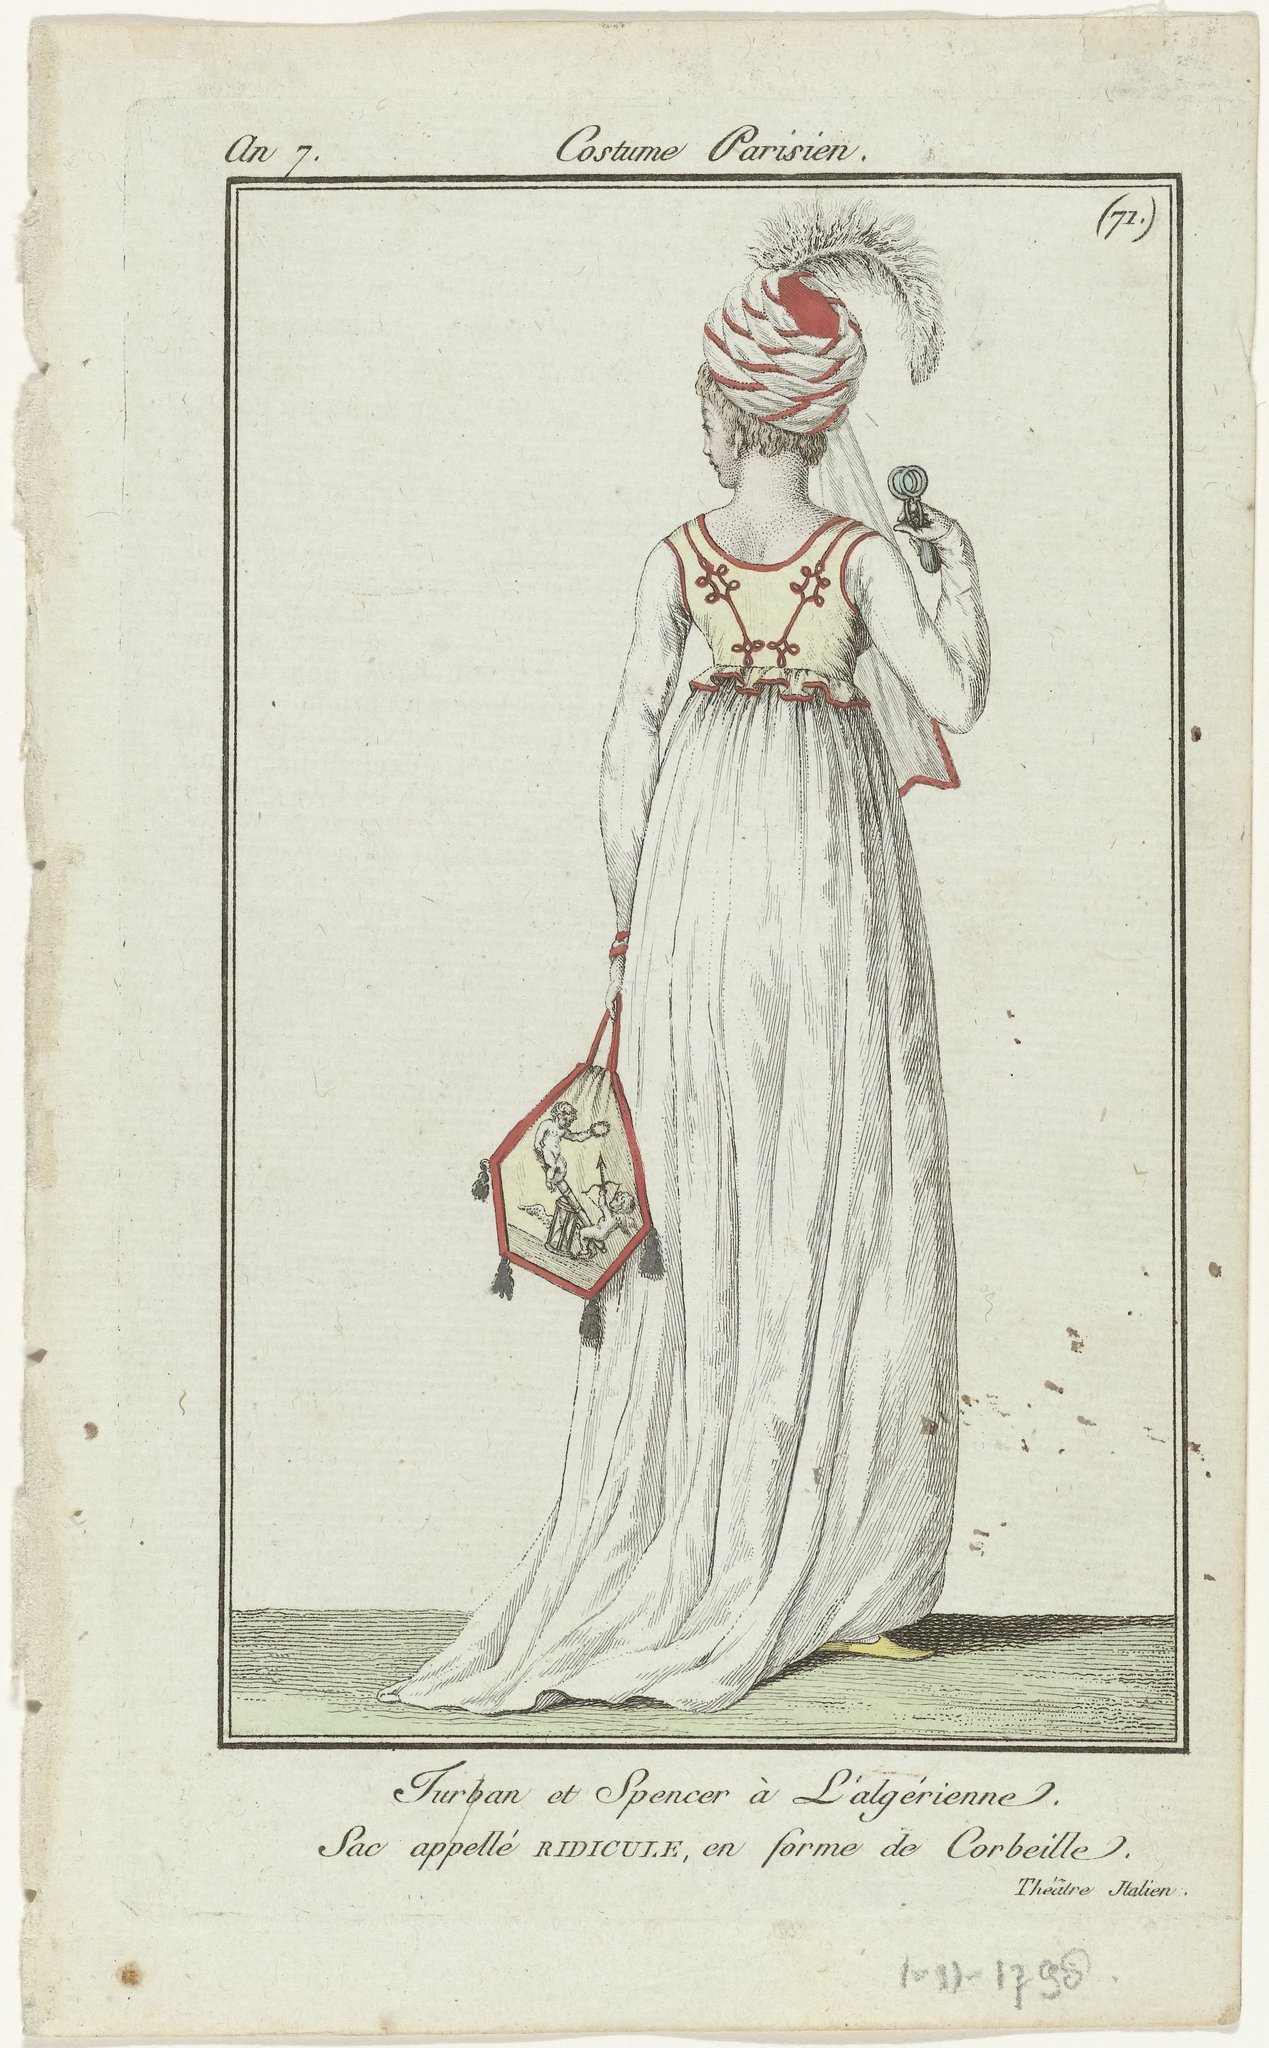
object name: fashion print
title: Journal des Dames et des Modes, Costume Parisien, 1 novembre 1798, An 7, (71) : Turban et Spencer (...)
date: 1798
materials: paper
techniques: engraving, hand coloring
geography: paris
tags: head-gear: turban (+ women's clothes), bag (reticule) (+ women's clothes), eyeglasses, spectacles (+ female (human being) (not to be used where -aa- is prescribed)), clothing for the upper part of the body (spencer) (+ women's clothes), fashion plates, shoes, sandals (+ women's clothes), dress, gown (+ women's clothes)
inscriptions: title: ‘Costume Parisien.’, caption: ‘Turban et Spencer à l'Algérienne. Sac appellé Ridicule, en forme de Corbeille. Théâtre Italien.’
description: Staande vrouw, op de rug gezien, met op het hoofd een tulband: 'turban à l'algérienne'. Zij draagt een 'spencer à l'algérienne' met lussenpatroon op een japon met sleep. Tas of 'sac' genaamd 'ridicule' (reticule), in de vorm van een 'Corbeille'. Volgens het onderschrift is deze voorstelling naar het leven getekend bij de 'Théâtre Italien'. De prent maakt deel uit van het modetijdschrift Journal des Dames et des Modes, uitgegeven door Sellèque, Parijs, 1797-1839.